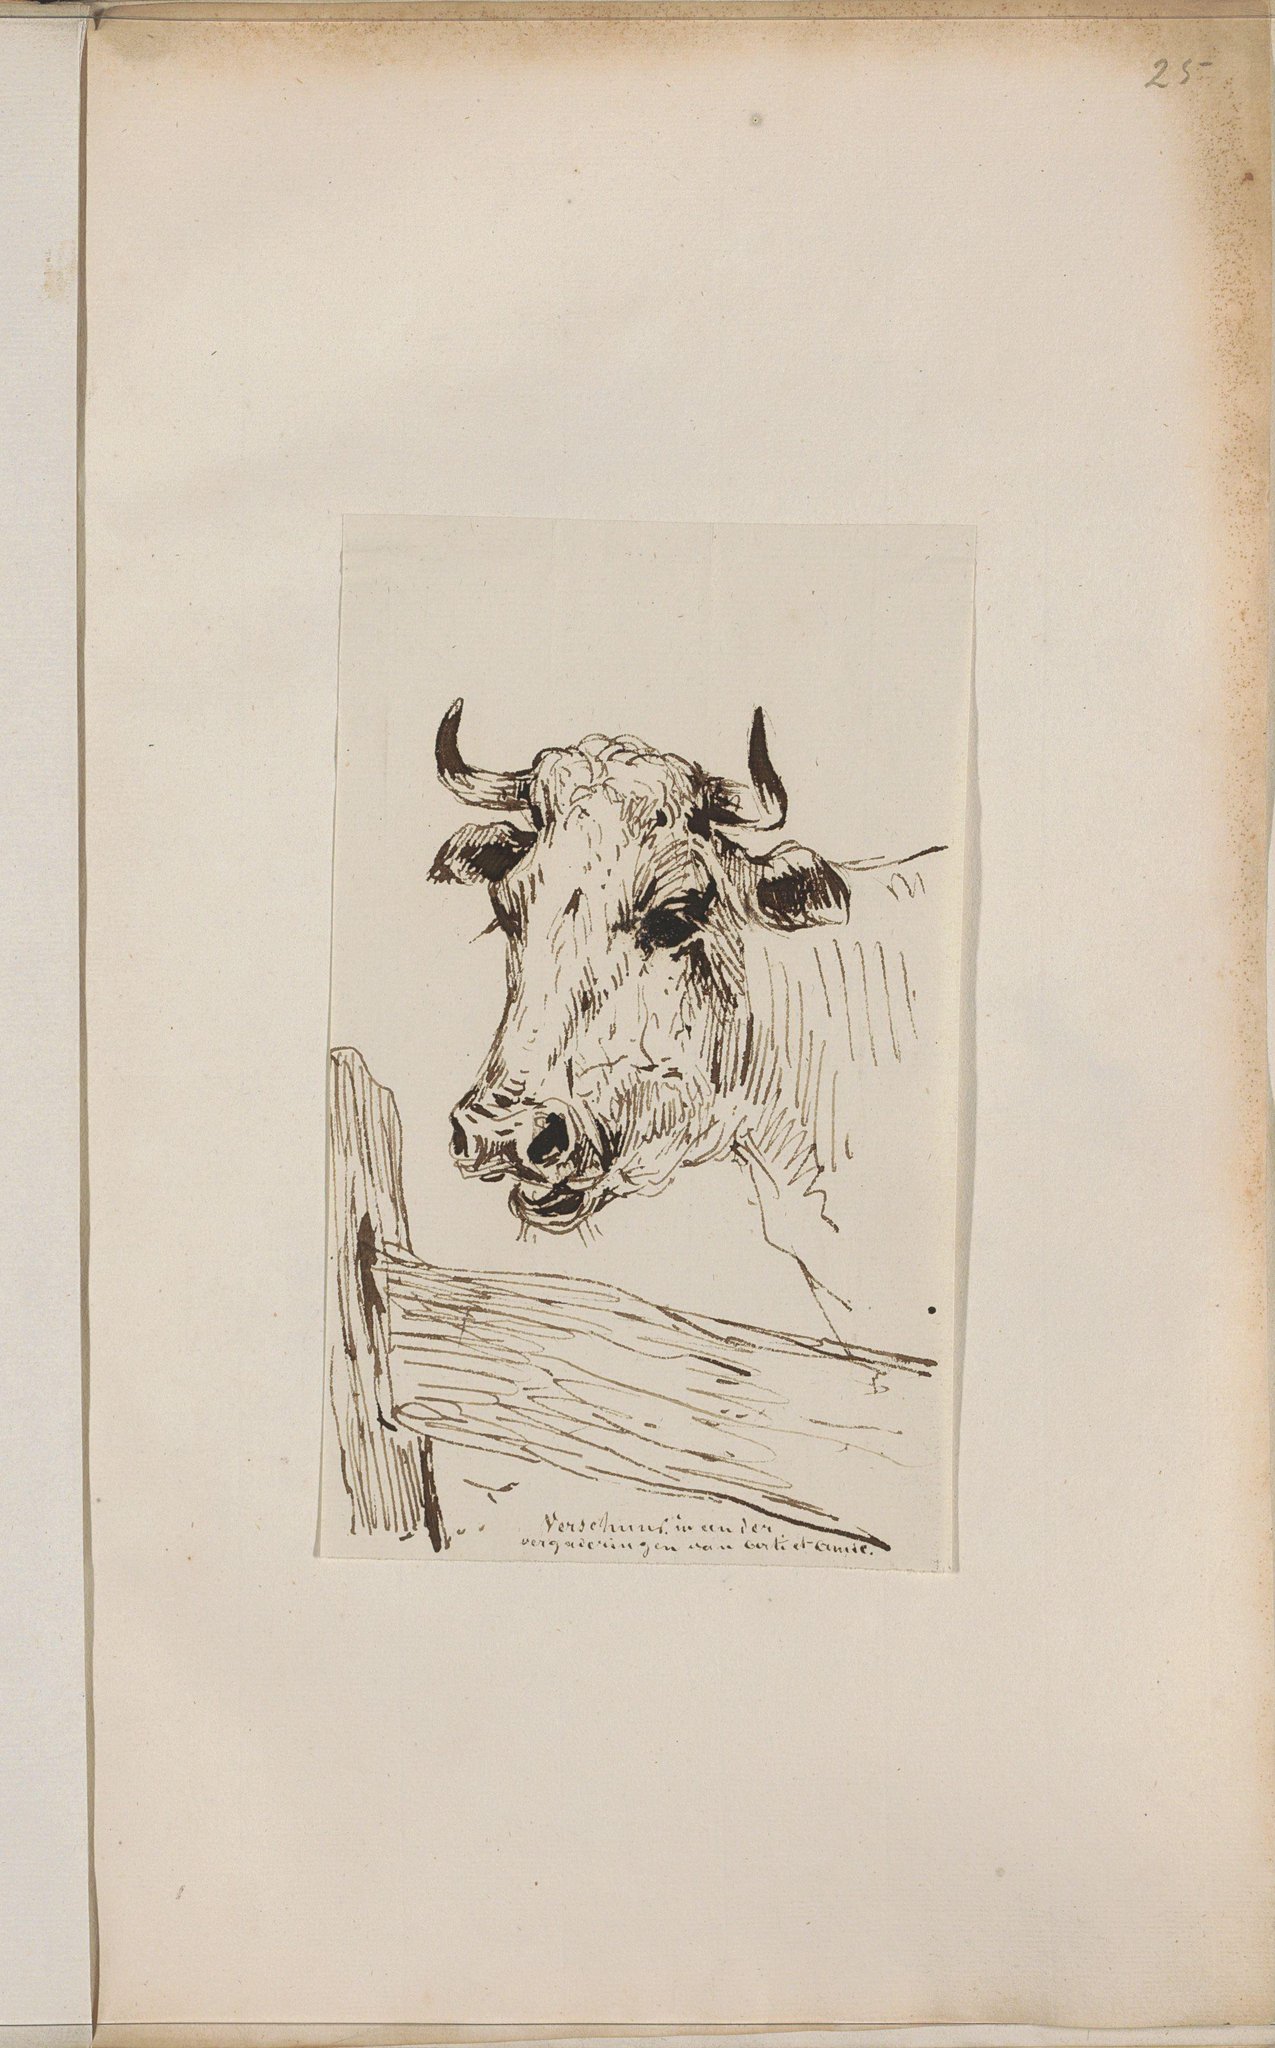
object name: album leaf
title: Os bij een hek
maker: wouter verschuur (1812-1874)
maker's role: draughtsman, painter, print maker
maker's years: 1812-1874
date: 1843-1864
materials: ink, paper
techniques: pen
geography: amsterdam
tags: fence, wall, paling, ox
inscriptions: annotation: ‘Verschuur in een der/ vergaderingen van Arti et Amic.’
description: Blad 25 recto uit een verzamelalbum met 32 bladen.